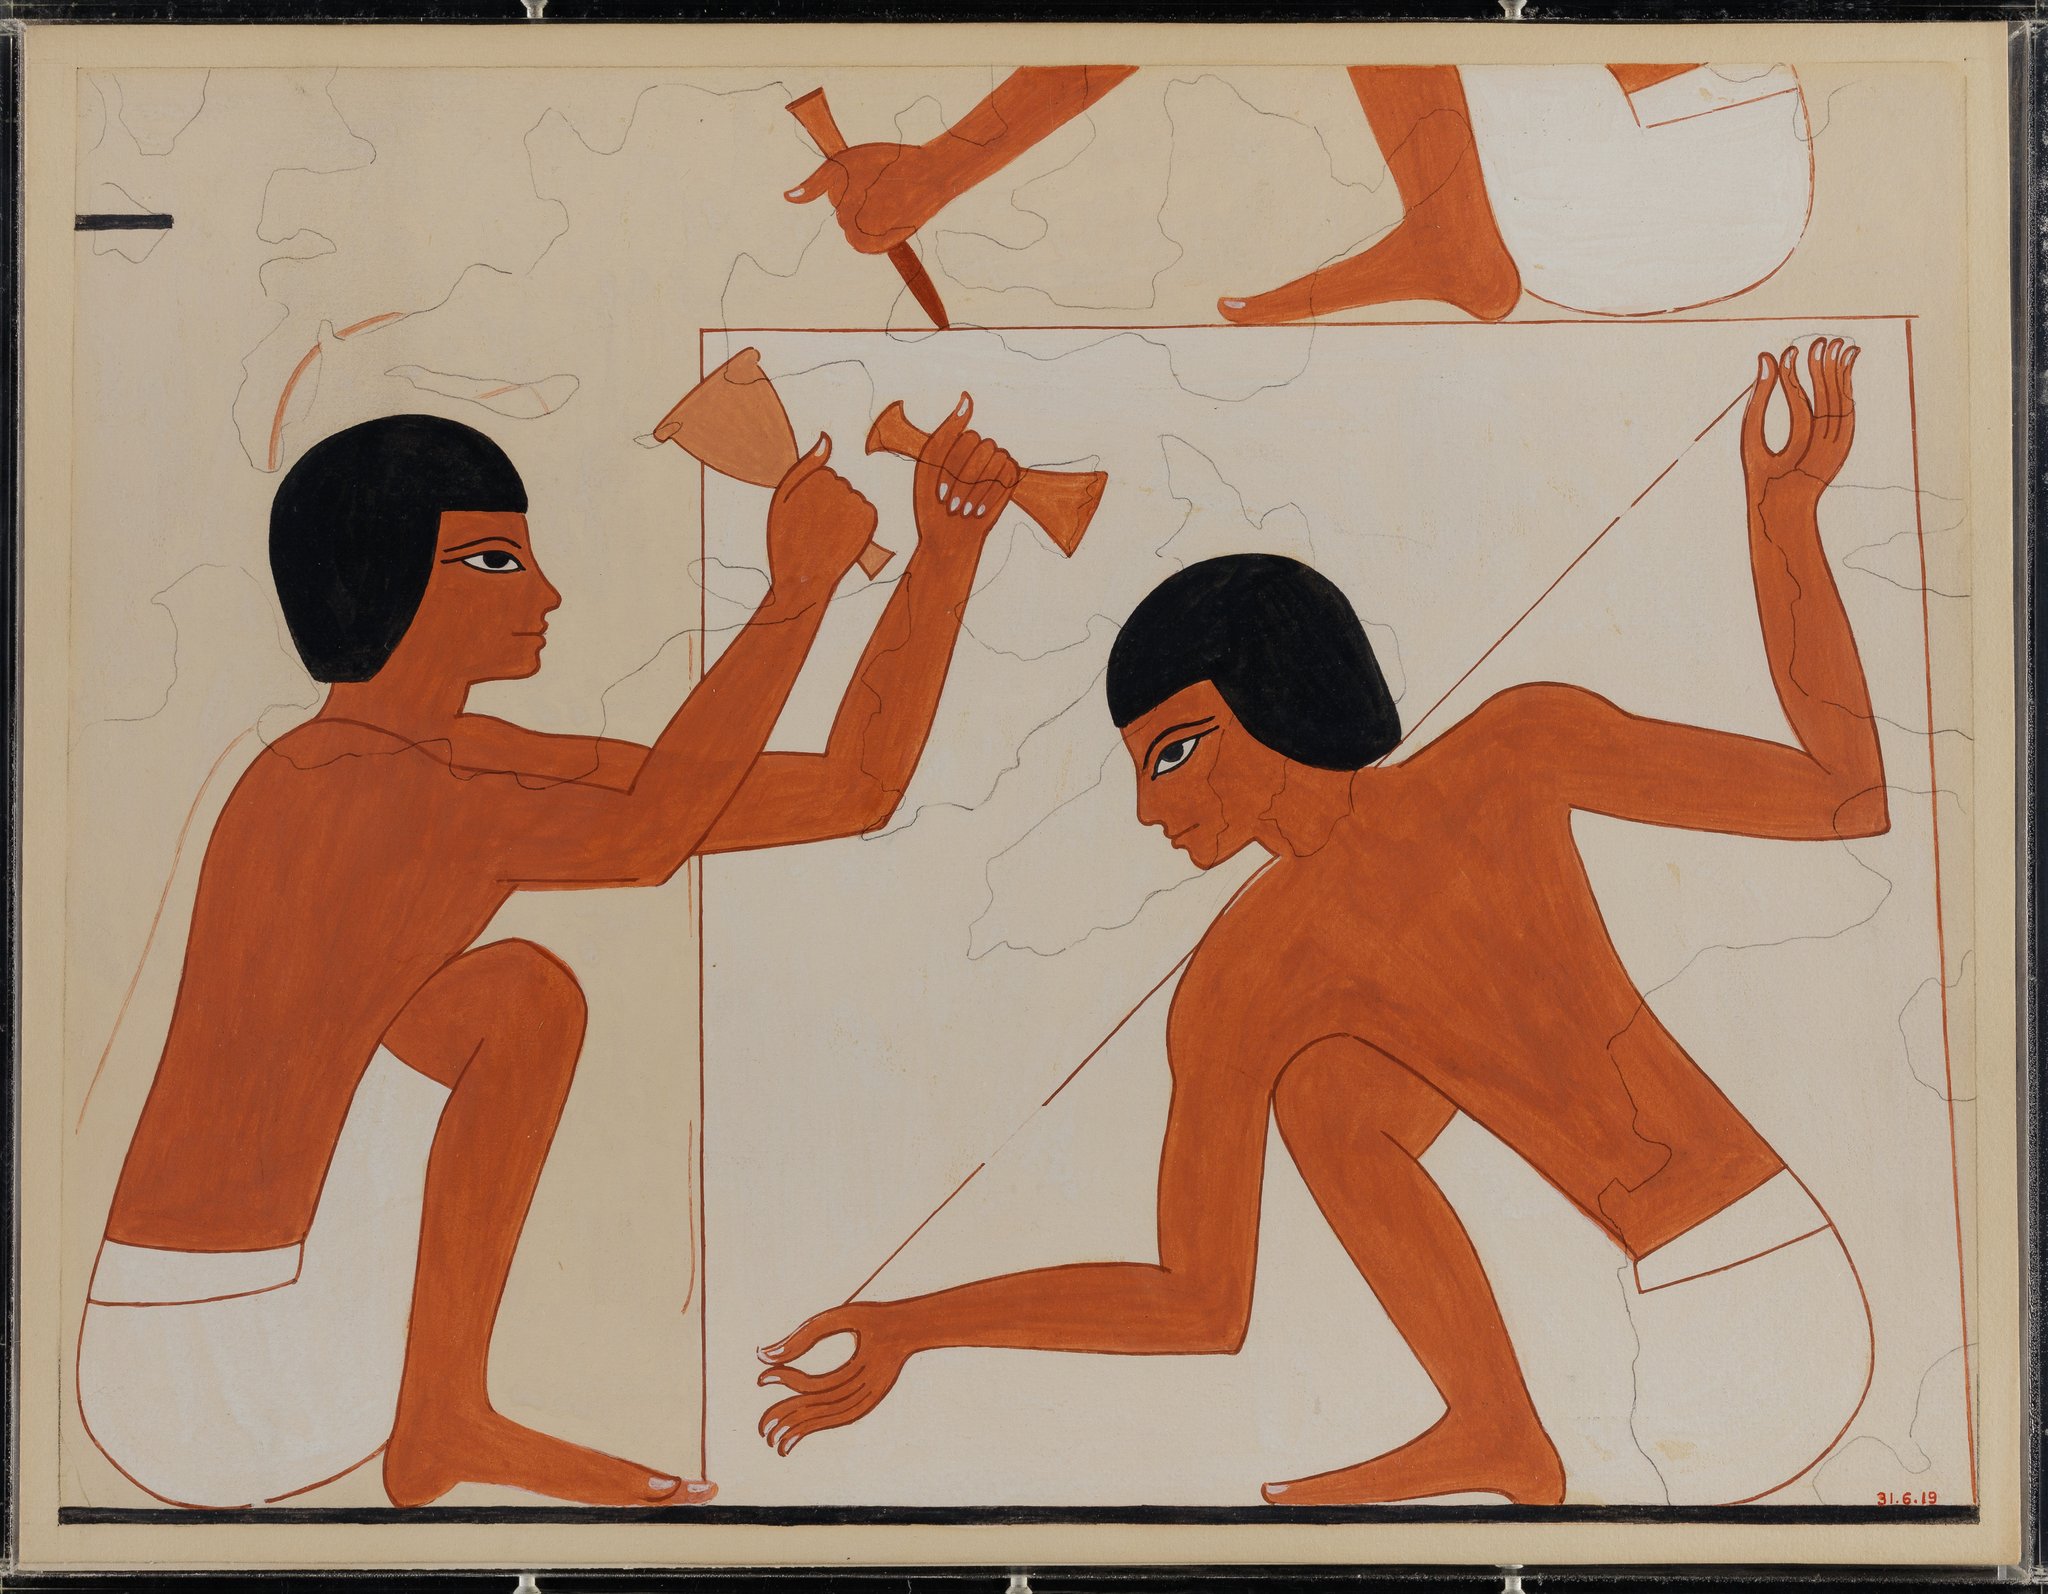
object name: restored copy, rekhmire tt 100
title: Masons Squaring a Block, Tomb of Rekhmire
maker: nina de garis davies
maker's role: artist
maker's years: 1881-1965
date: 1479-1425 BCE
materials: paper, paint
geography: egypt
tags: men,working